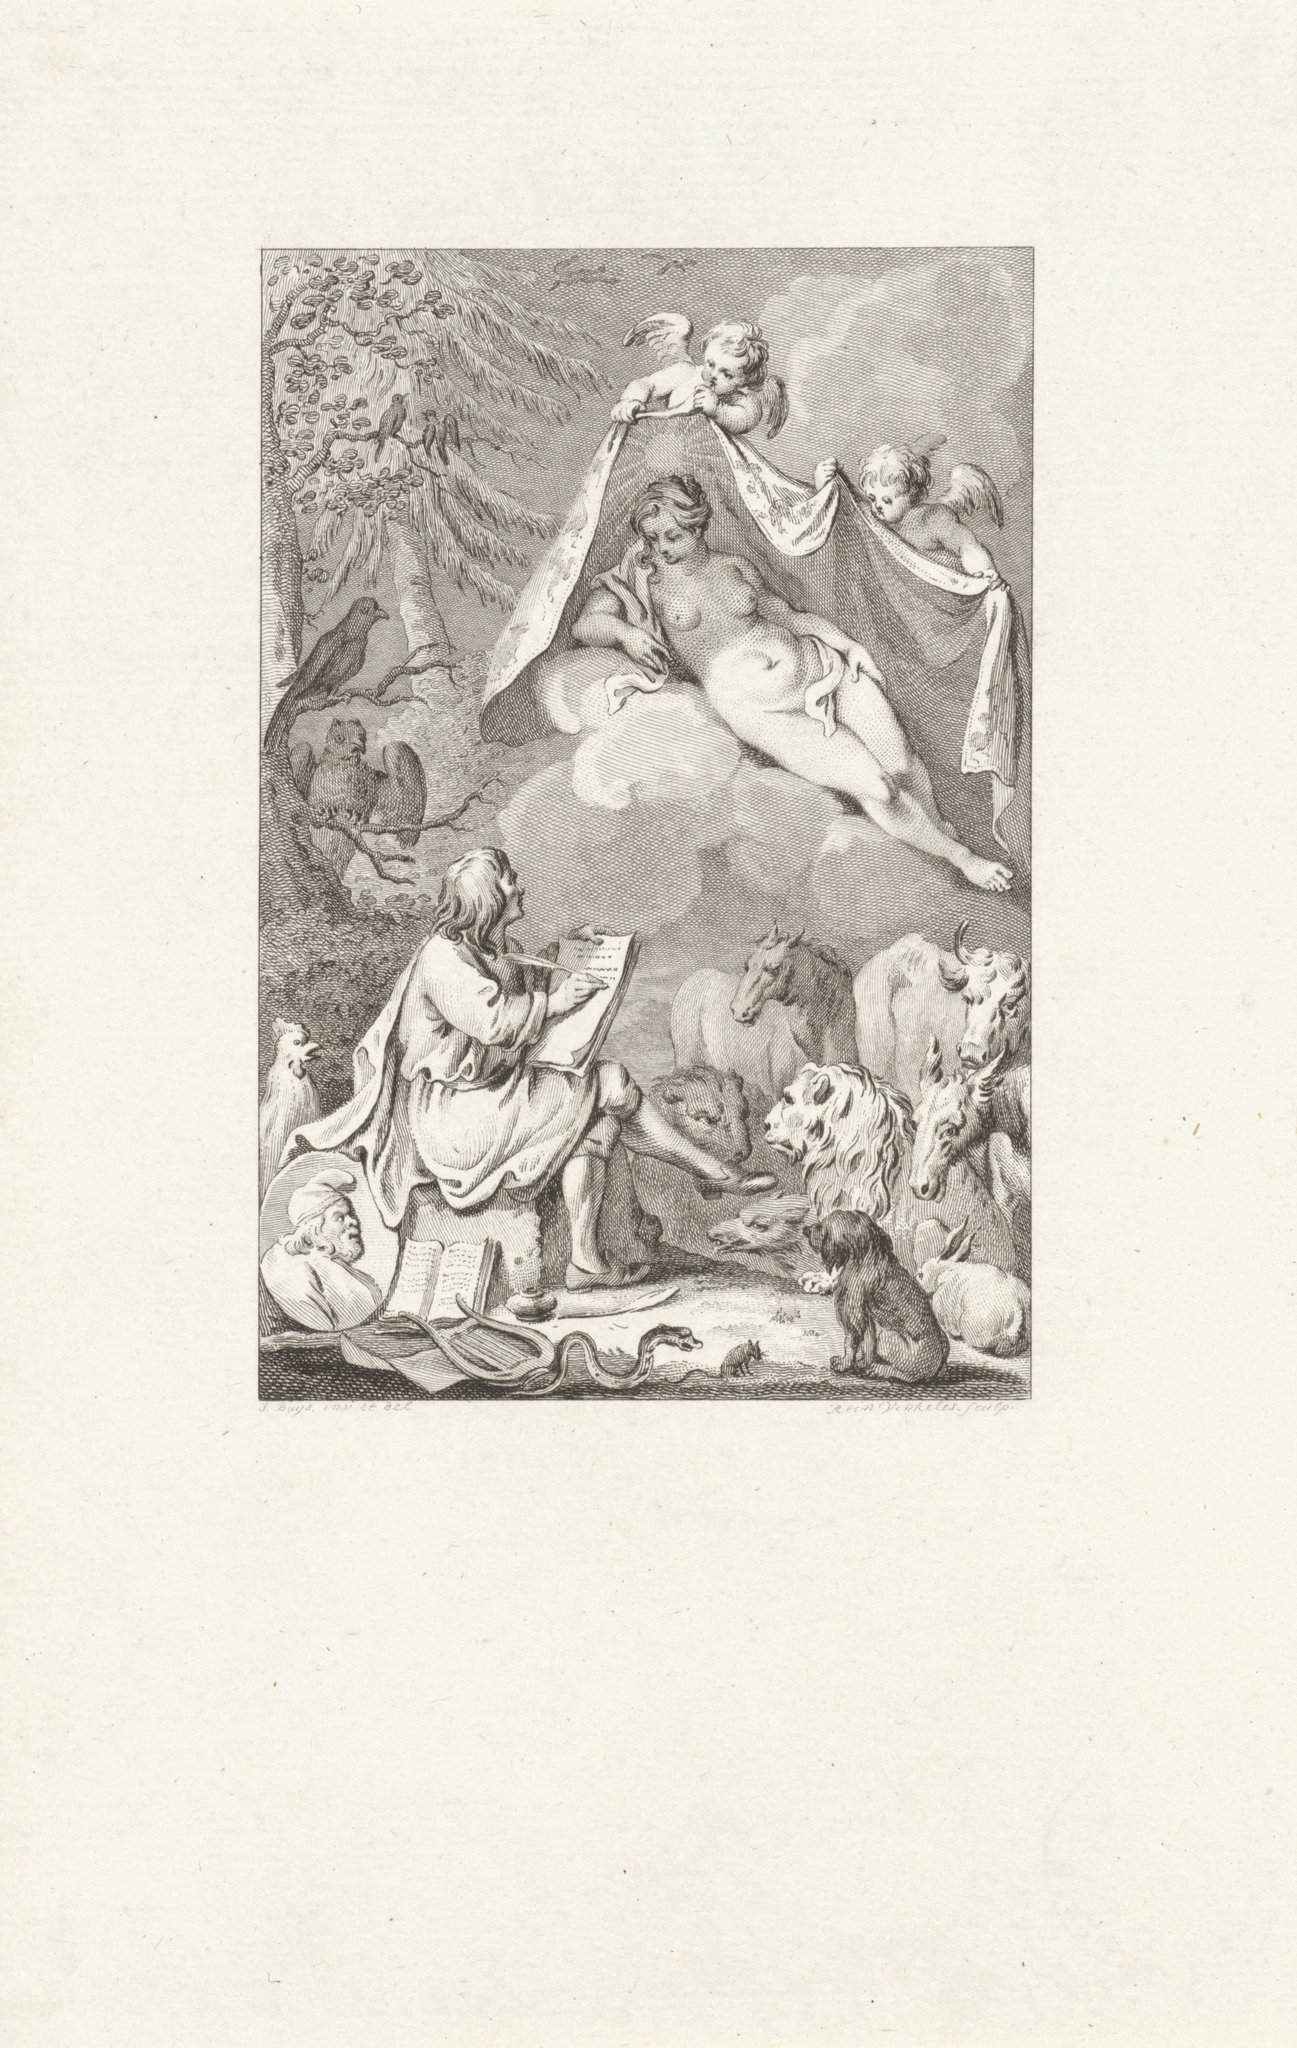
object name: print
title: Allegorie met de schrijver Jean de La Fontaine en zijn muze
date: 1786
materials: paper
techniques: engraving, etching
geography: amsterdam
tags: aesopus, snakes, truth; 'verità' (ripa), author, poet writing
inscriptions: collector's mark: Lugt 240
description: In een bos laat een schrijver, mogelijk Jean de La Fontaine, zich inspireren door een vrouwelijke personificatie van de Waarheid, die onthuld wordt door twee putti. Om hem hebben zich verschillende dieren verzameld. Op de voorgrond een lier en een portret in profiel van de Griekse fabelschrijver Aesop.